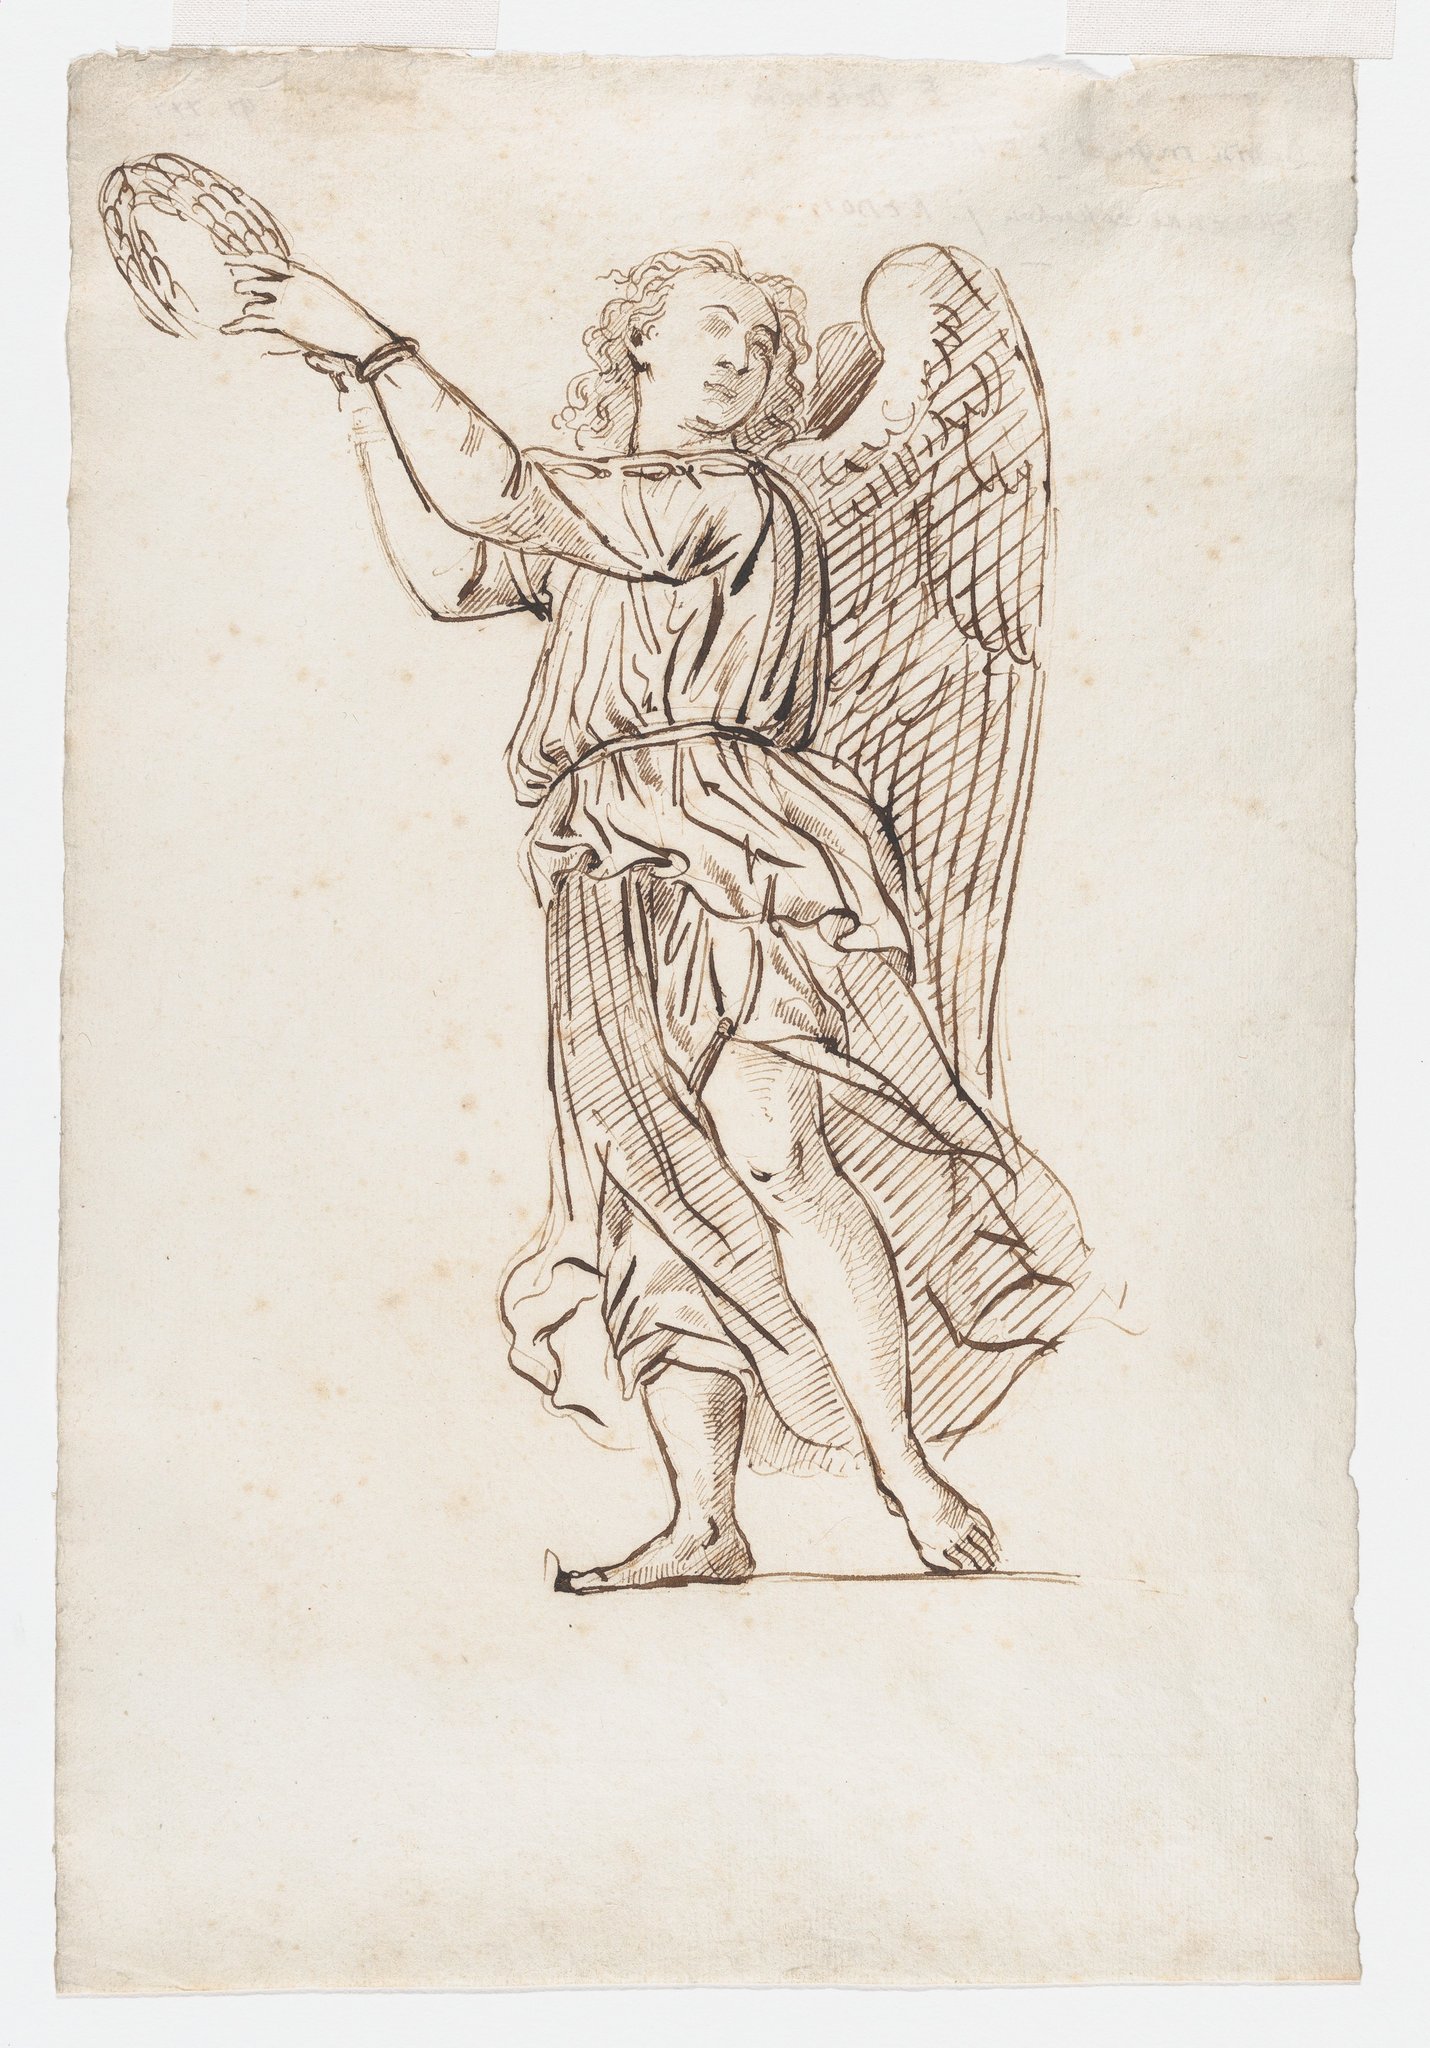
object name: drawing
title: Angel with a Crown of Laurel, or Figure of Victory after Mantegna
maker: eugène delacroix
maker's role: artist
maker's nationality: french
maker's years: 1798-1863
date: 1820-1829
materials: ink, iron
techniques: pen